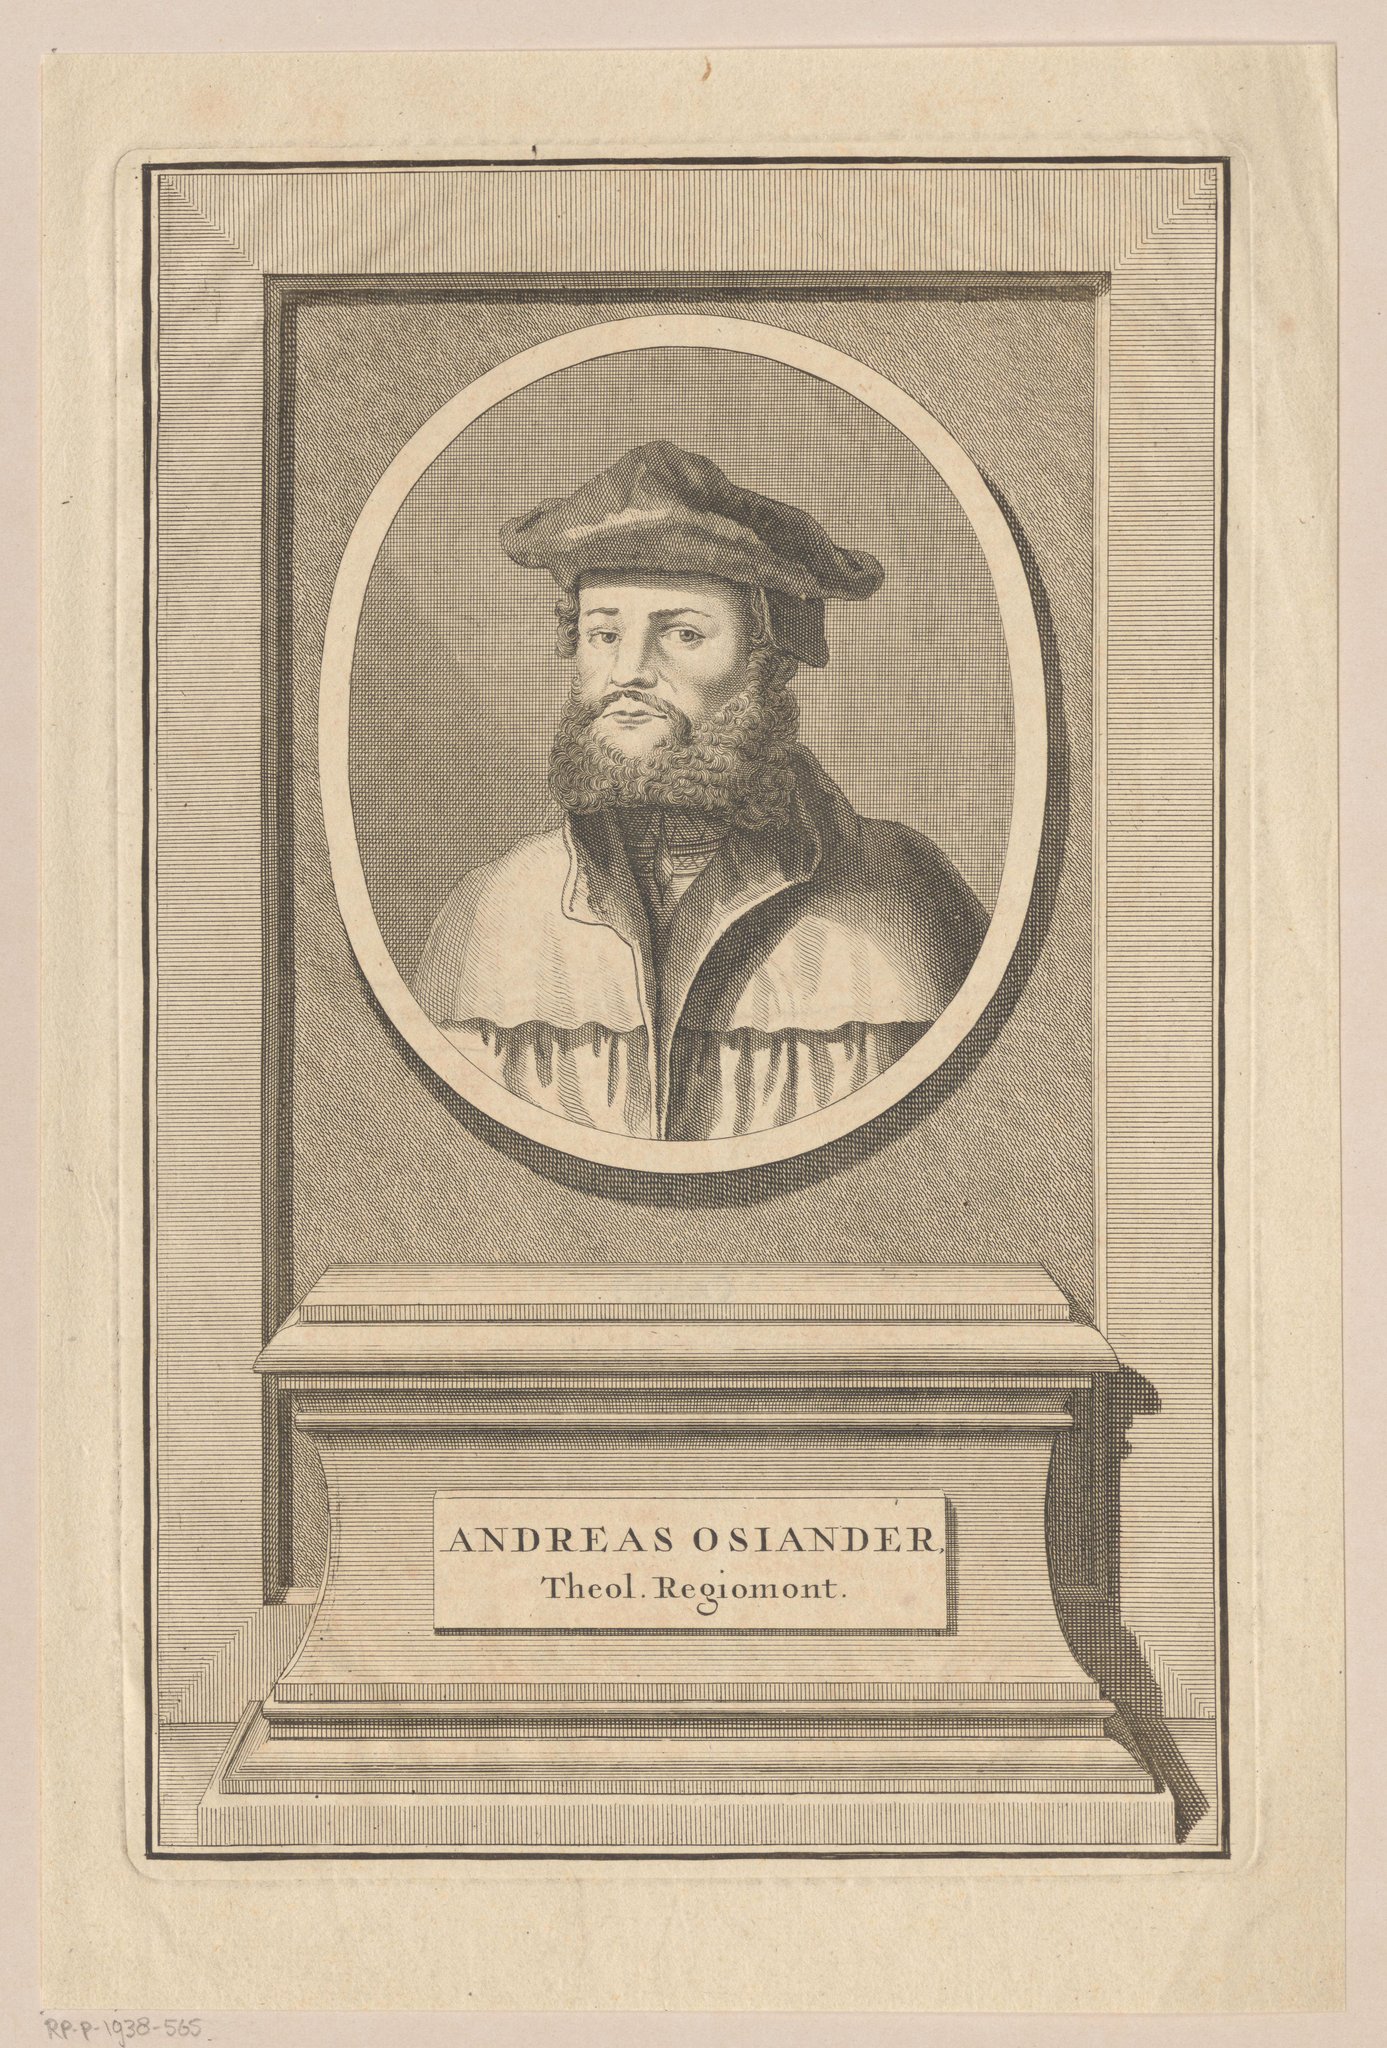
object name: print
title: Portret van Andreas Osiander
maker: Anonymous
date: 1728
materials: paper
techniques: etching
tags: theologian, historical persons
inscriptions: collector's mark: Lugt 2228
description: Prent mogelijk uit: Seckendorf, Veit-Ludwig. Uitvoerige en onpartydige historie der reformatie door Martin Luther. Delft: Reinier Boitet, 1728, dl. 1.